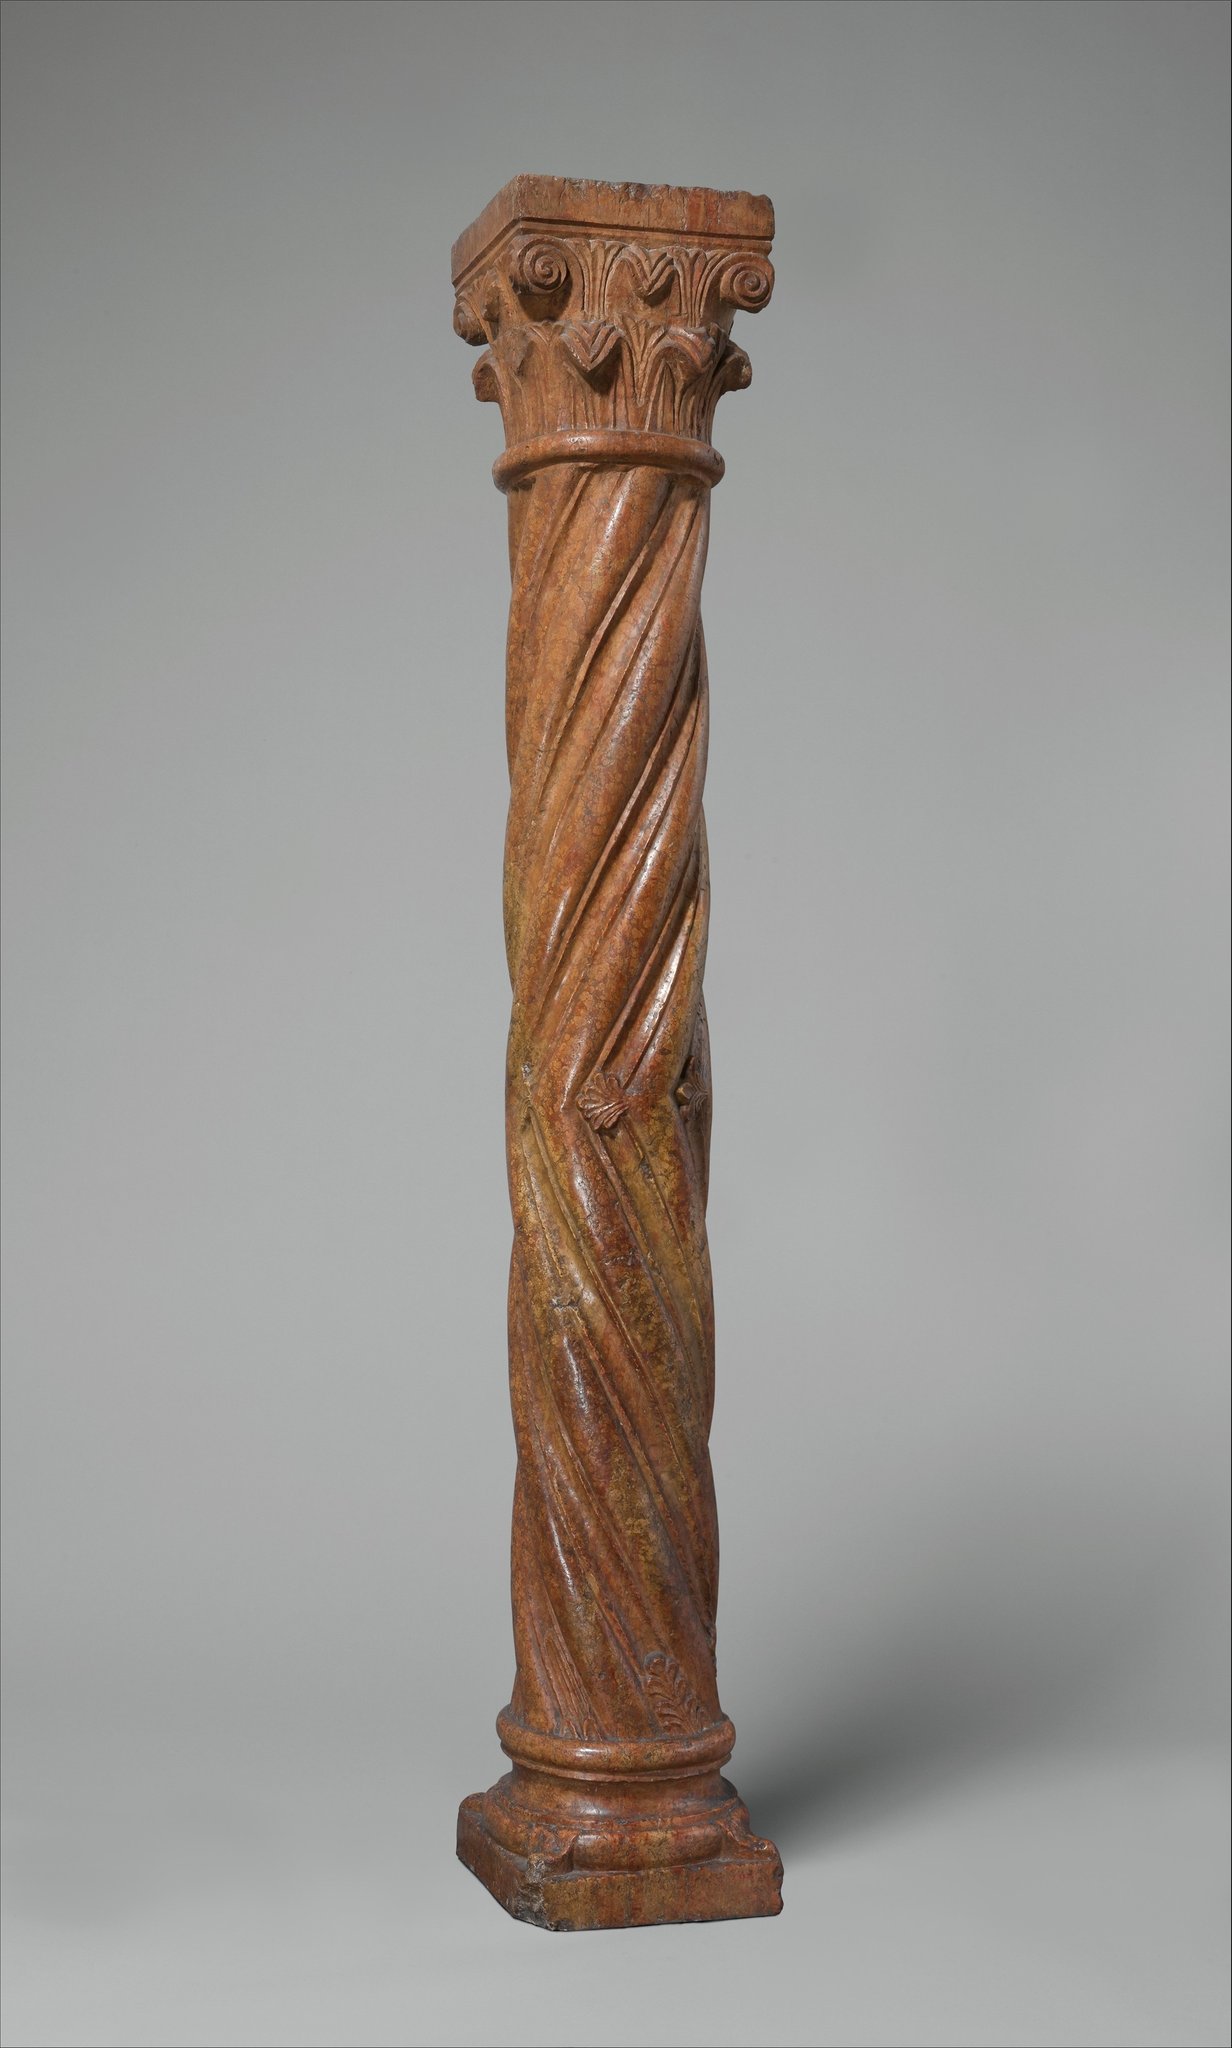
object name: column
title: Column and Capital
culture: north italian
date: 1301-1400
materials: limestone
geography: italy